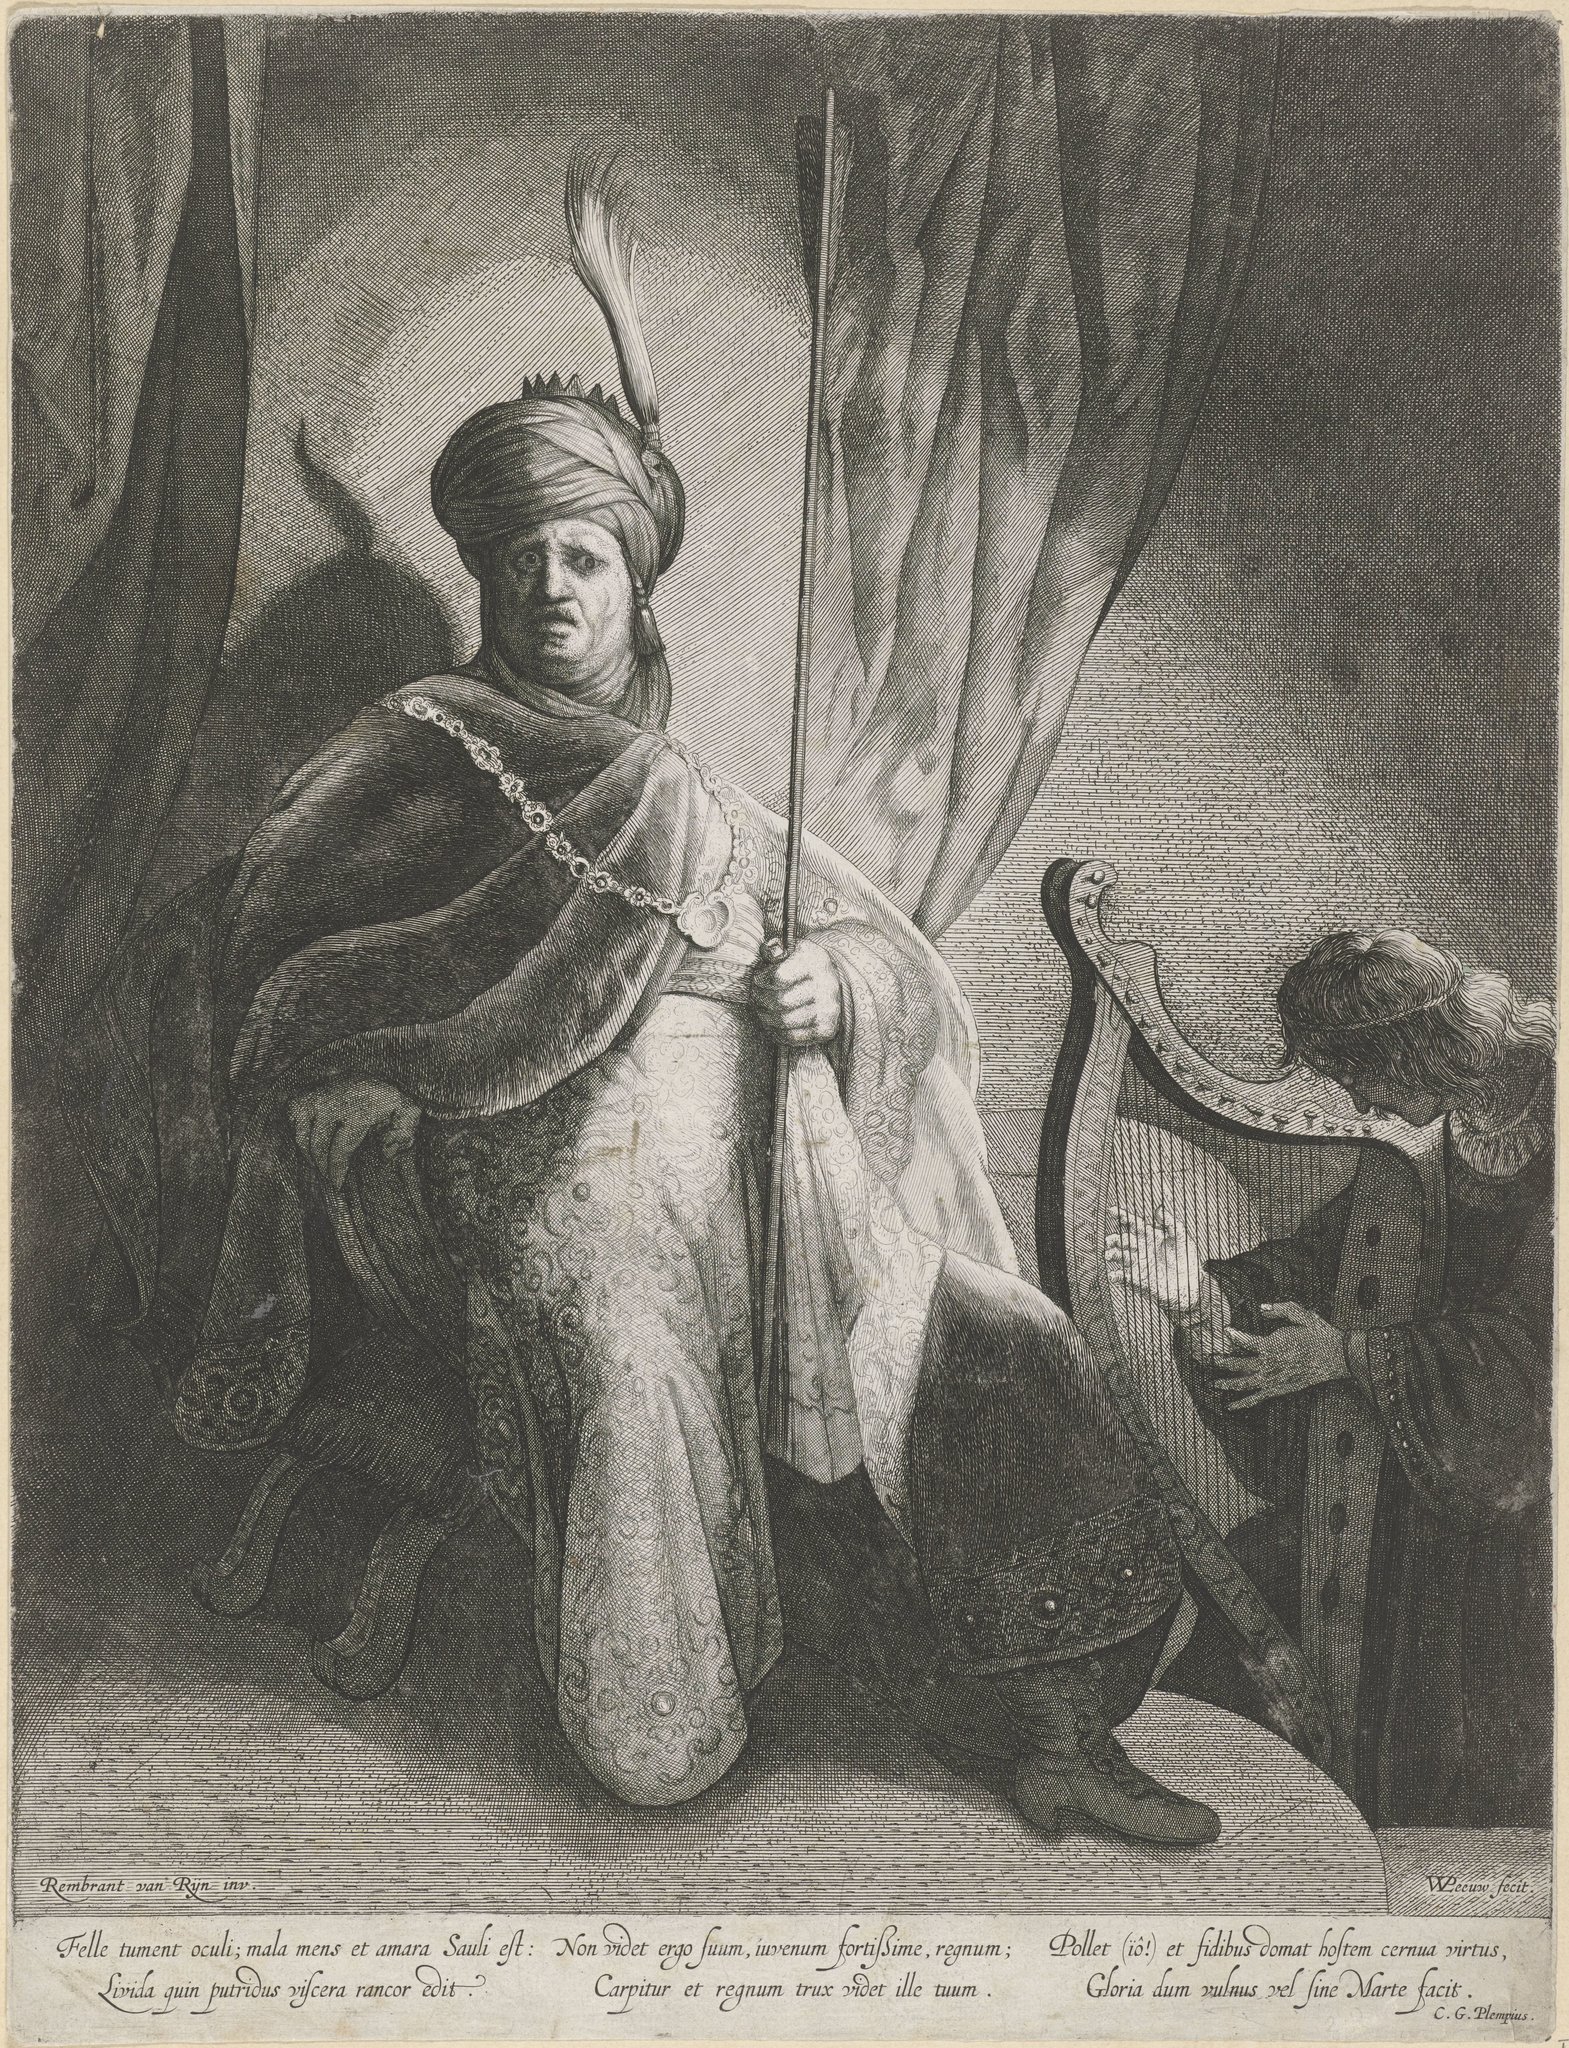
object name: print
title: David speelt de harp voor Saul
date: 1616-1665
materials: paper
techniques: engraving, etching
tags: david playing his harp before saul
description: Koning Saul zit op een troon met een speer in zijn hand, naast hem bespeelt David de harp. In de marge een zesregelige tekst in Latijn.